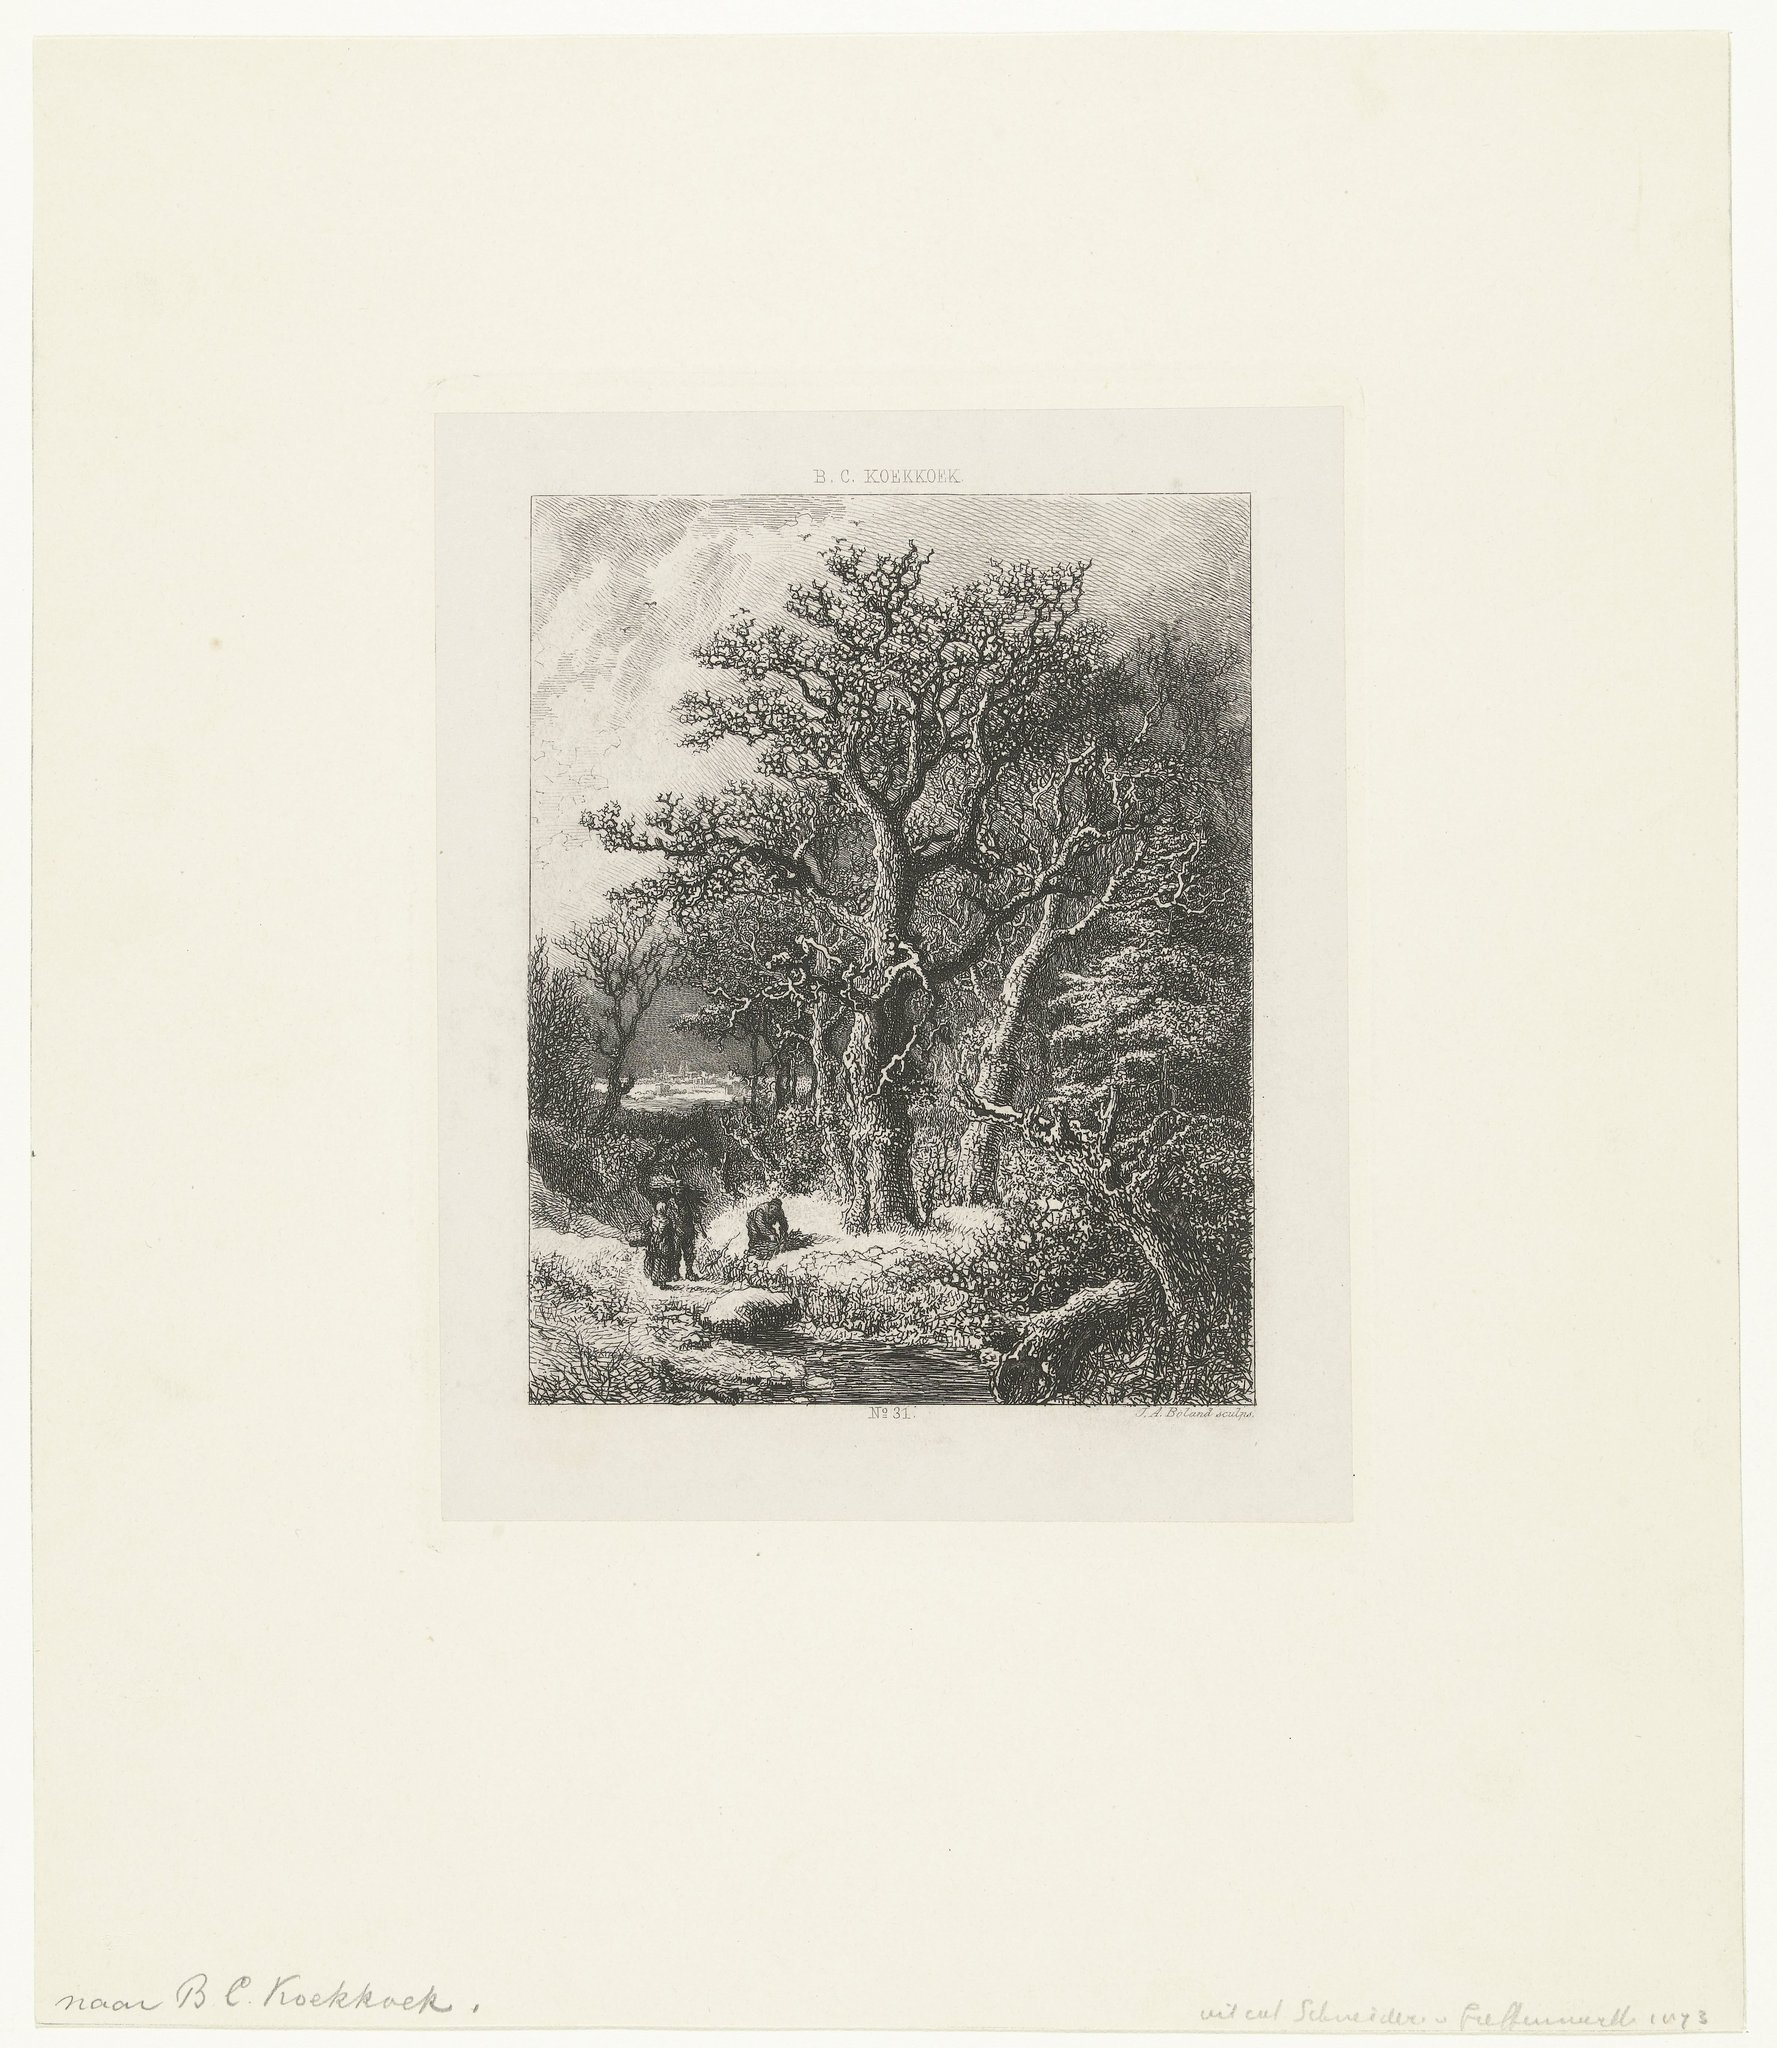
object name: print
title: Winterlandschap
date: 1860-1900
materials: paper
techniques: etching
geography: amsterdam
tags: landscapes, snow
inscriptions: collector's mark: Lugt 2165